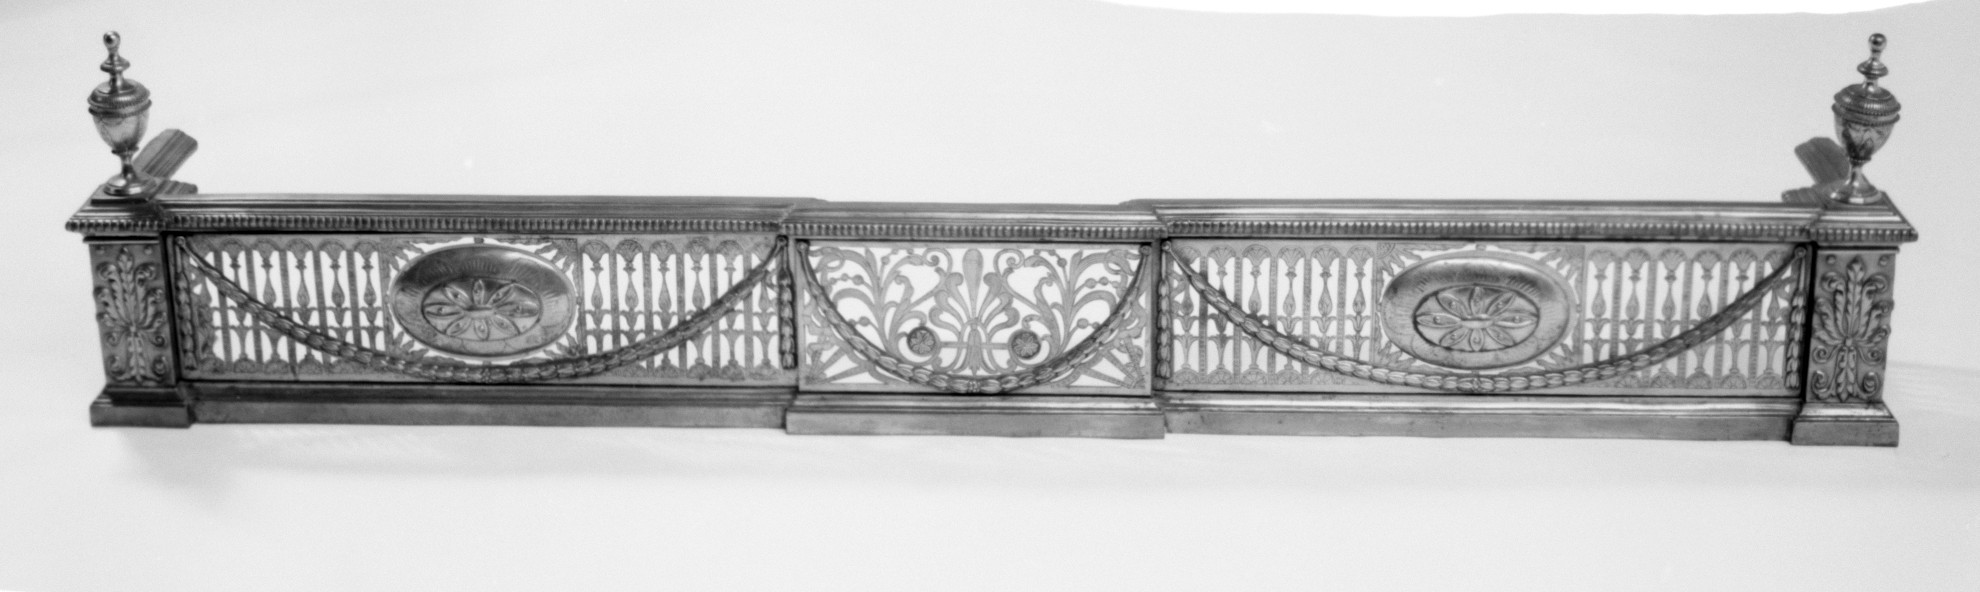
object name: fender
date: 1780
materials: steel